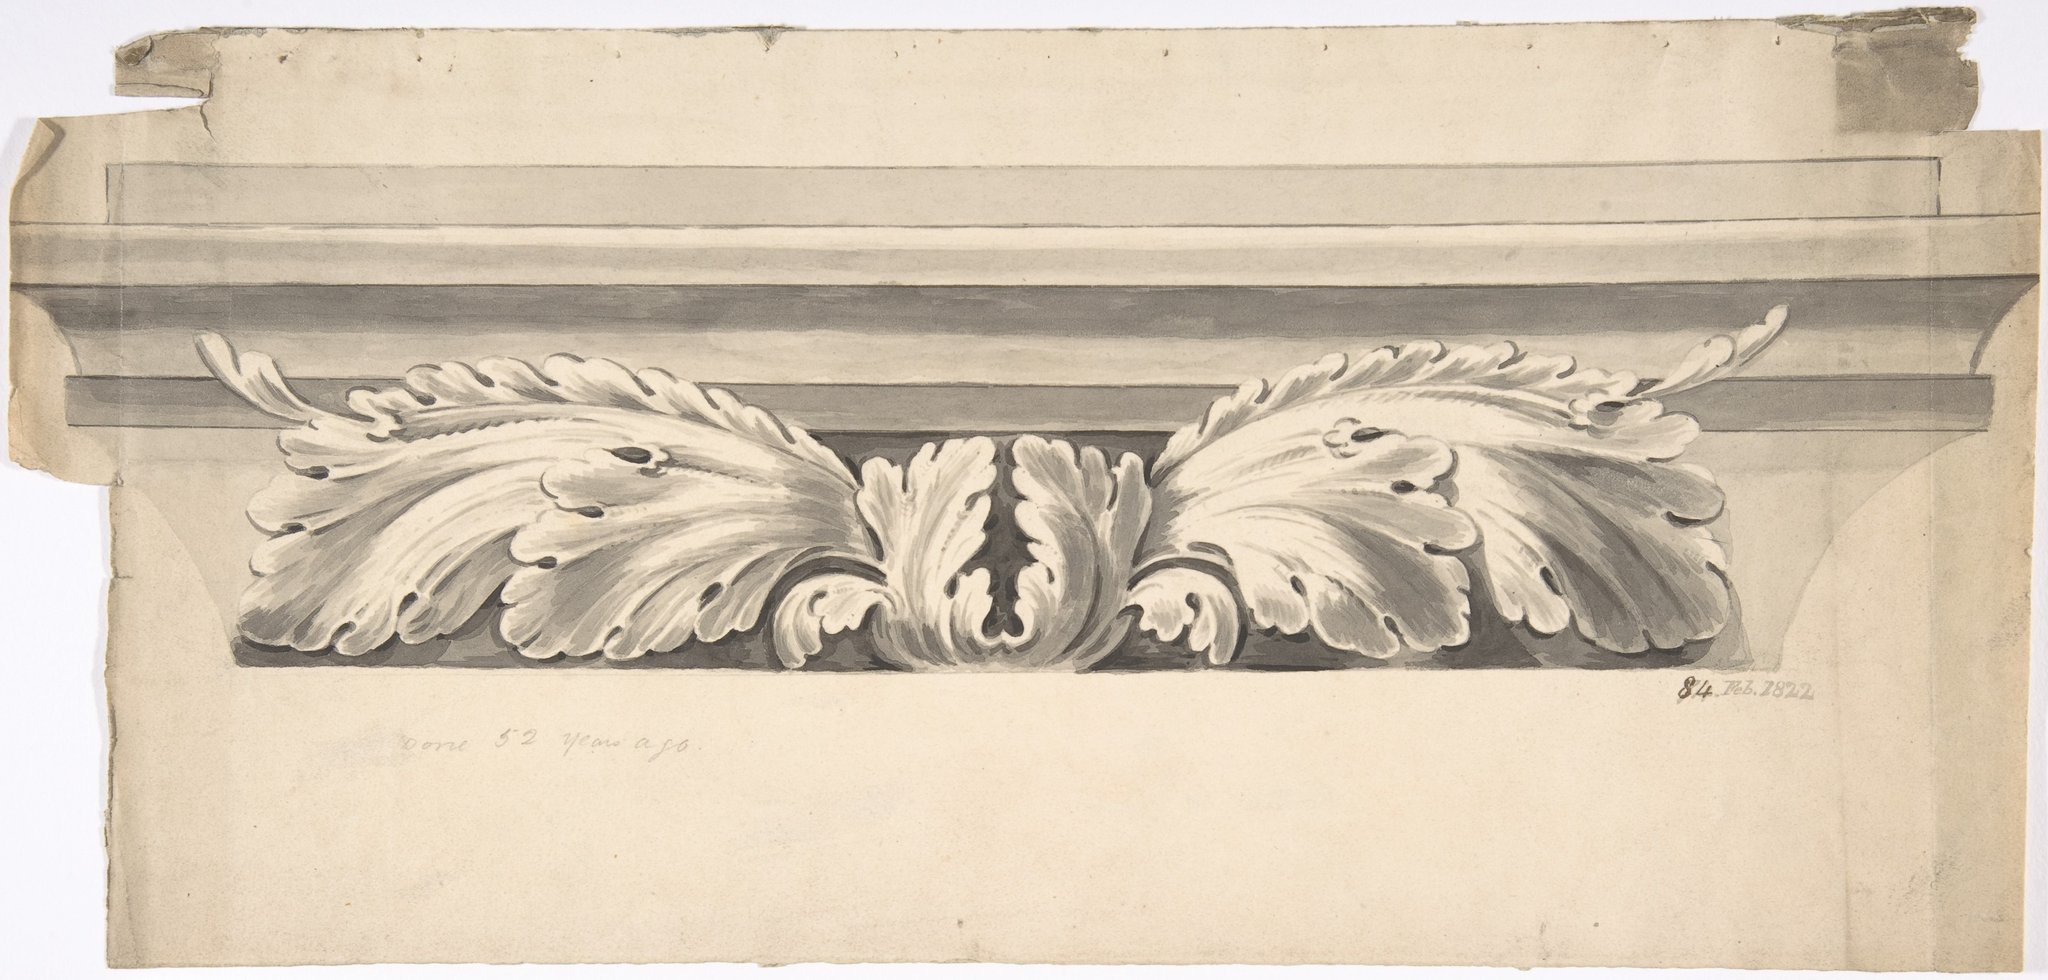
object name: drawing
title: Design for an Entablature Carved with Acanthus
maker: anonymous, british, 19th century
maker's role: artist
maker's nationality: british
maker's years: 1800-1900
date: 1822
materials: ink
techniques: brush, pen, wash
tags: ornament,acanthus